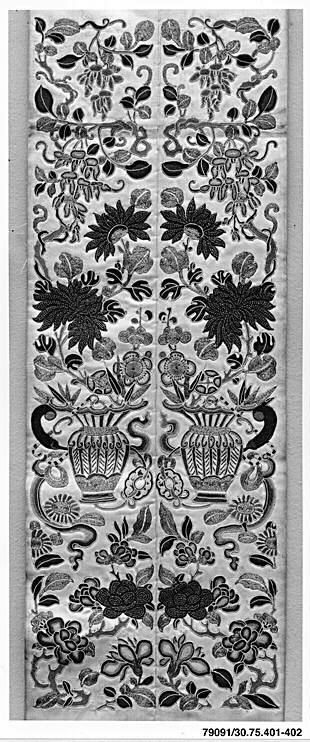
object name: sleeve band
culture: chinese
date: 1801-1900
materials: metal thread, silk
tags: flowers,plants